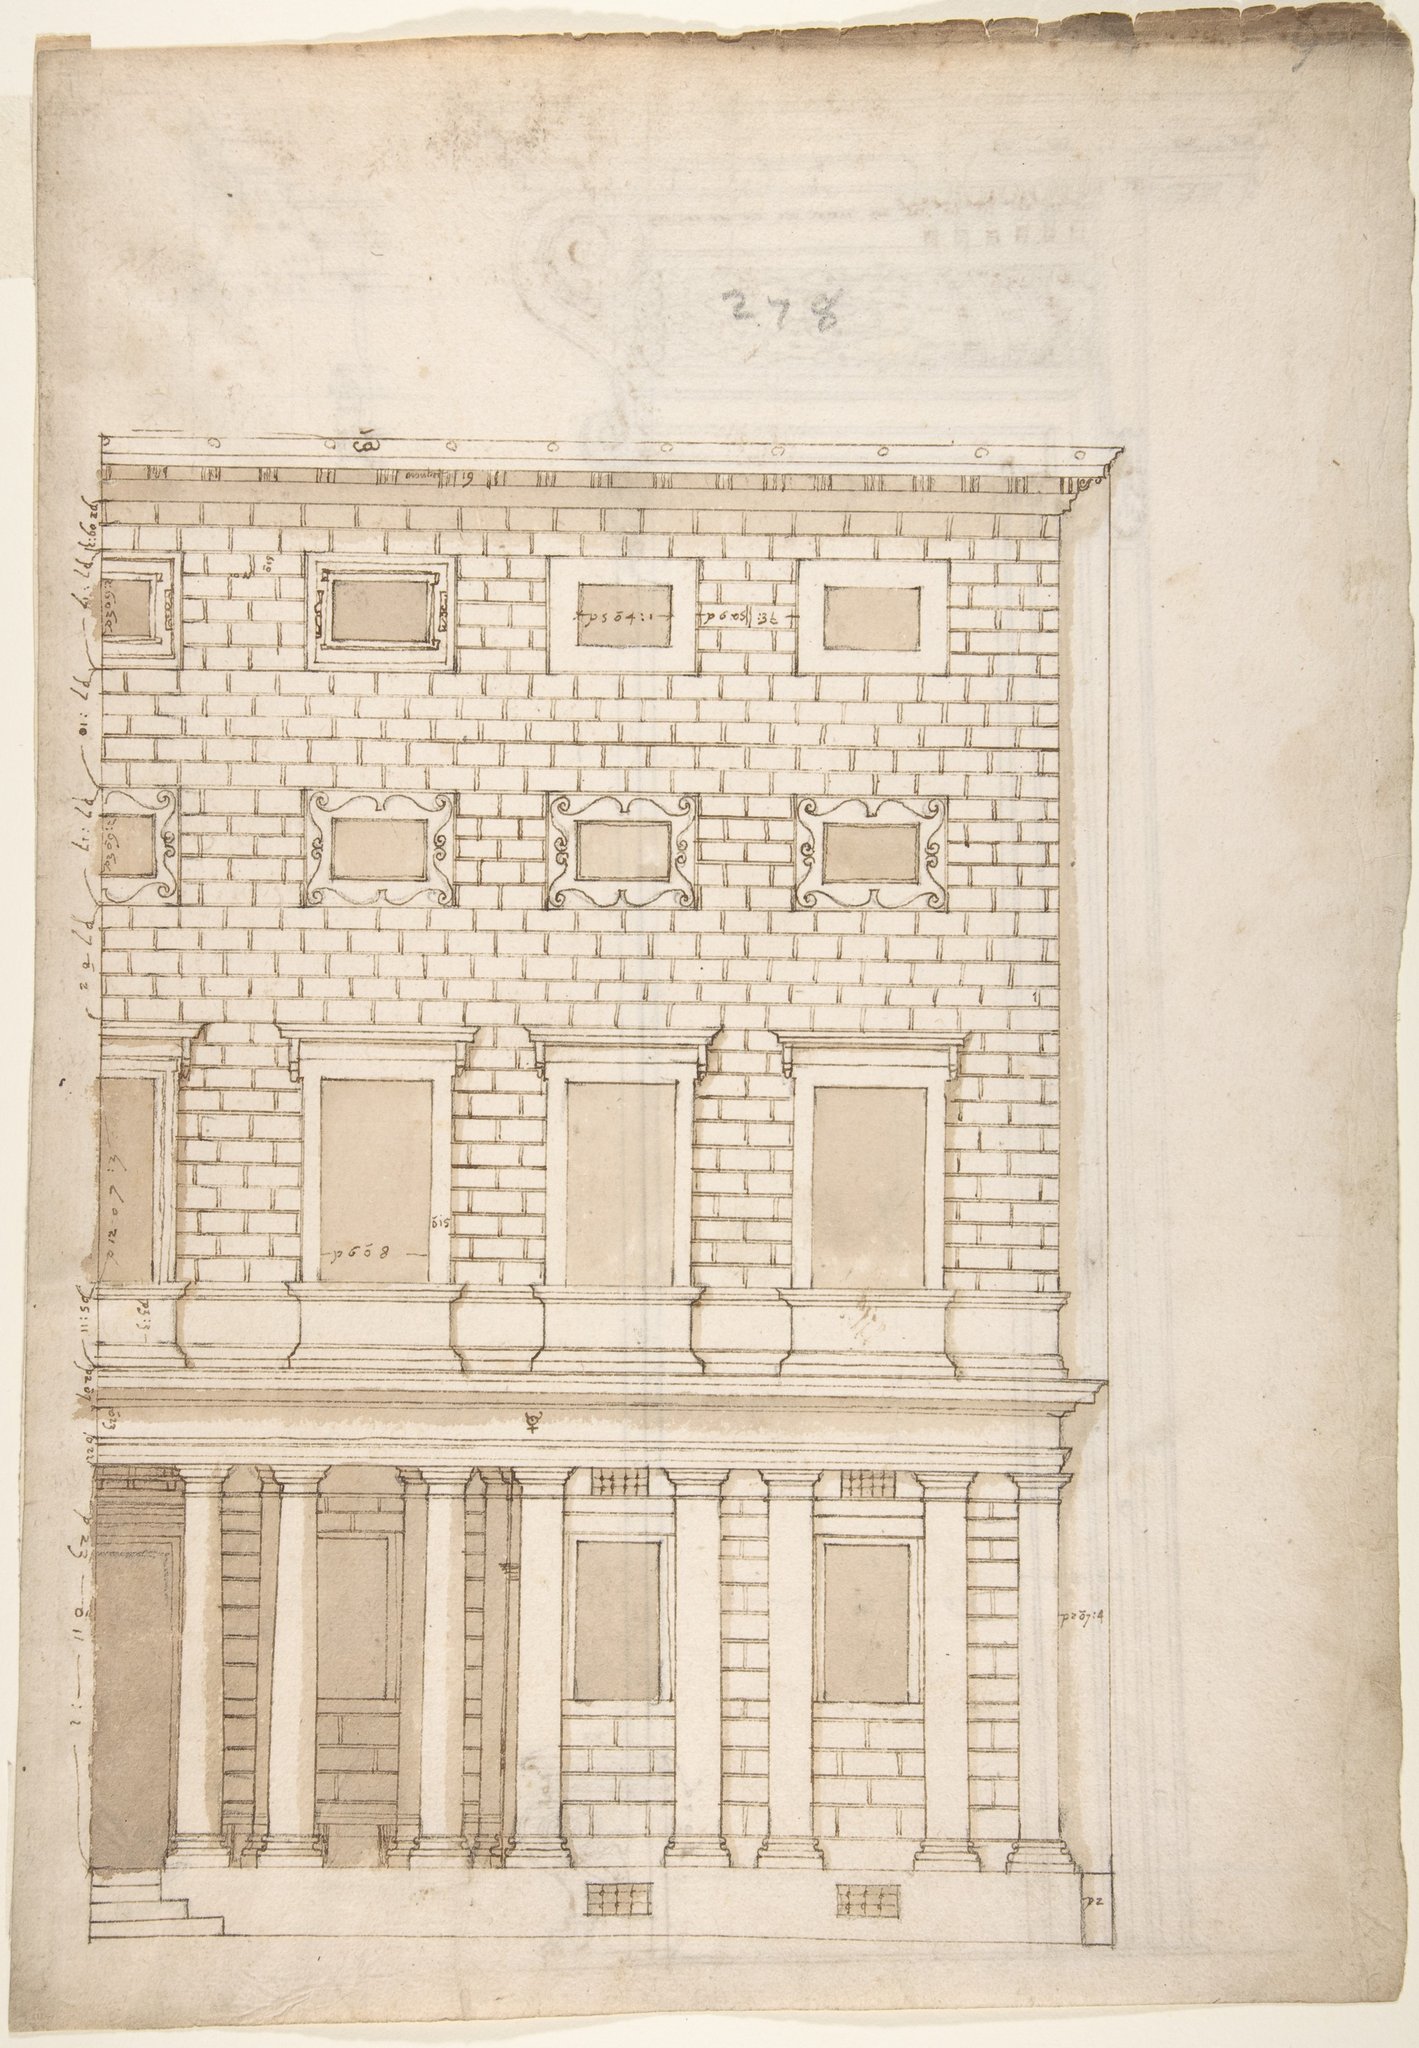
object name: drawing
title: Palazzo Massimo alle Colonne, elevation (recto) Palazzo Massimo alle Colonne, portal, elevation; portal entablature, profile (verso)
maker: anonymous, french, 16th century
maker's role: draftsman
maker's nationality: french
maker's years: 1500-1600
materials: chalk, ink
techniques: incising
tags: architecture,buildings